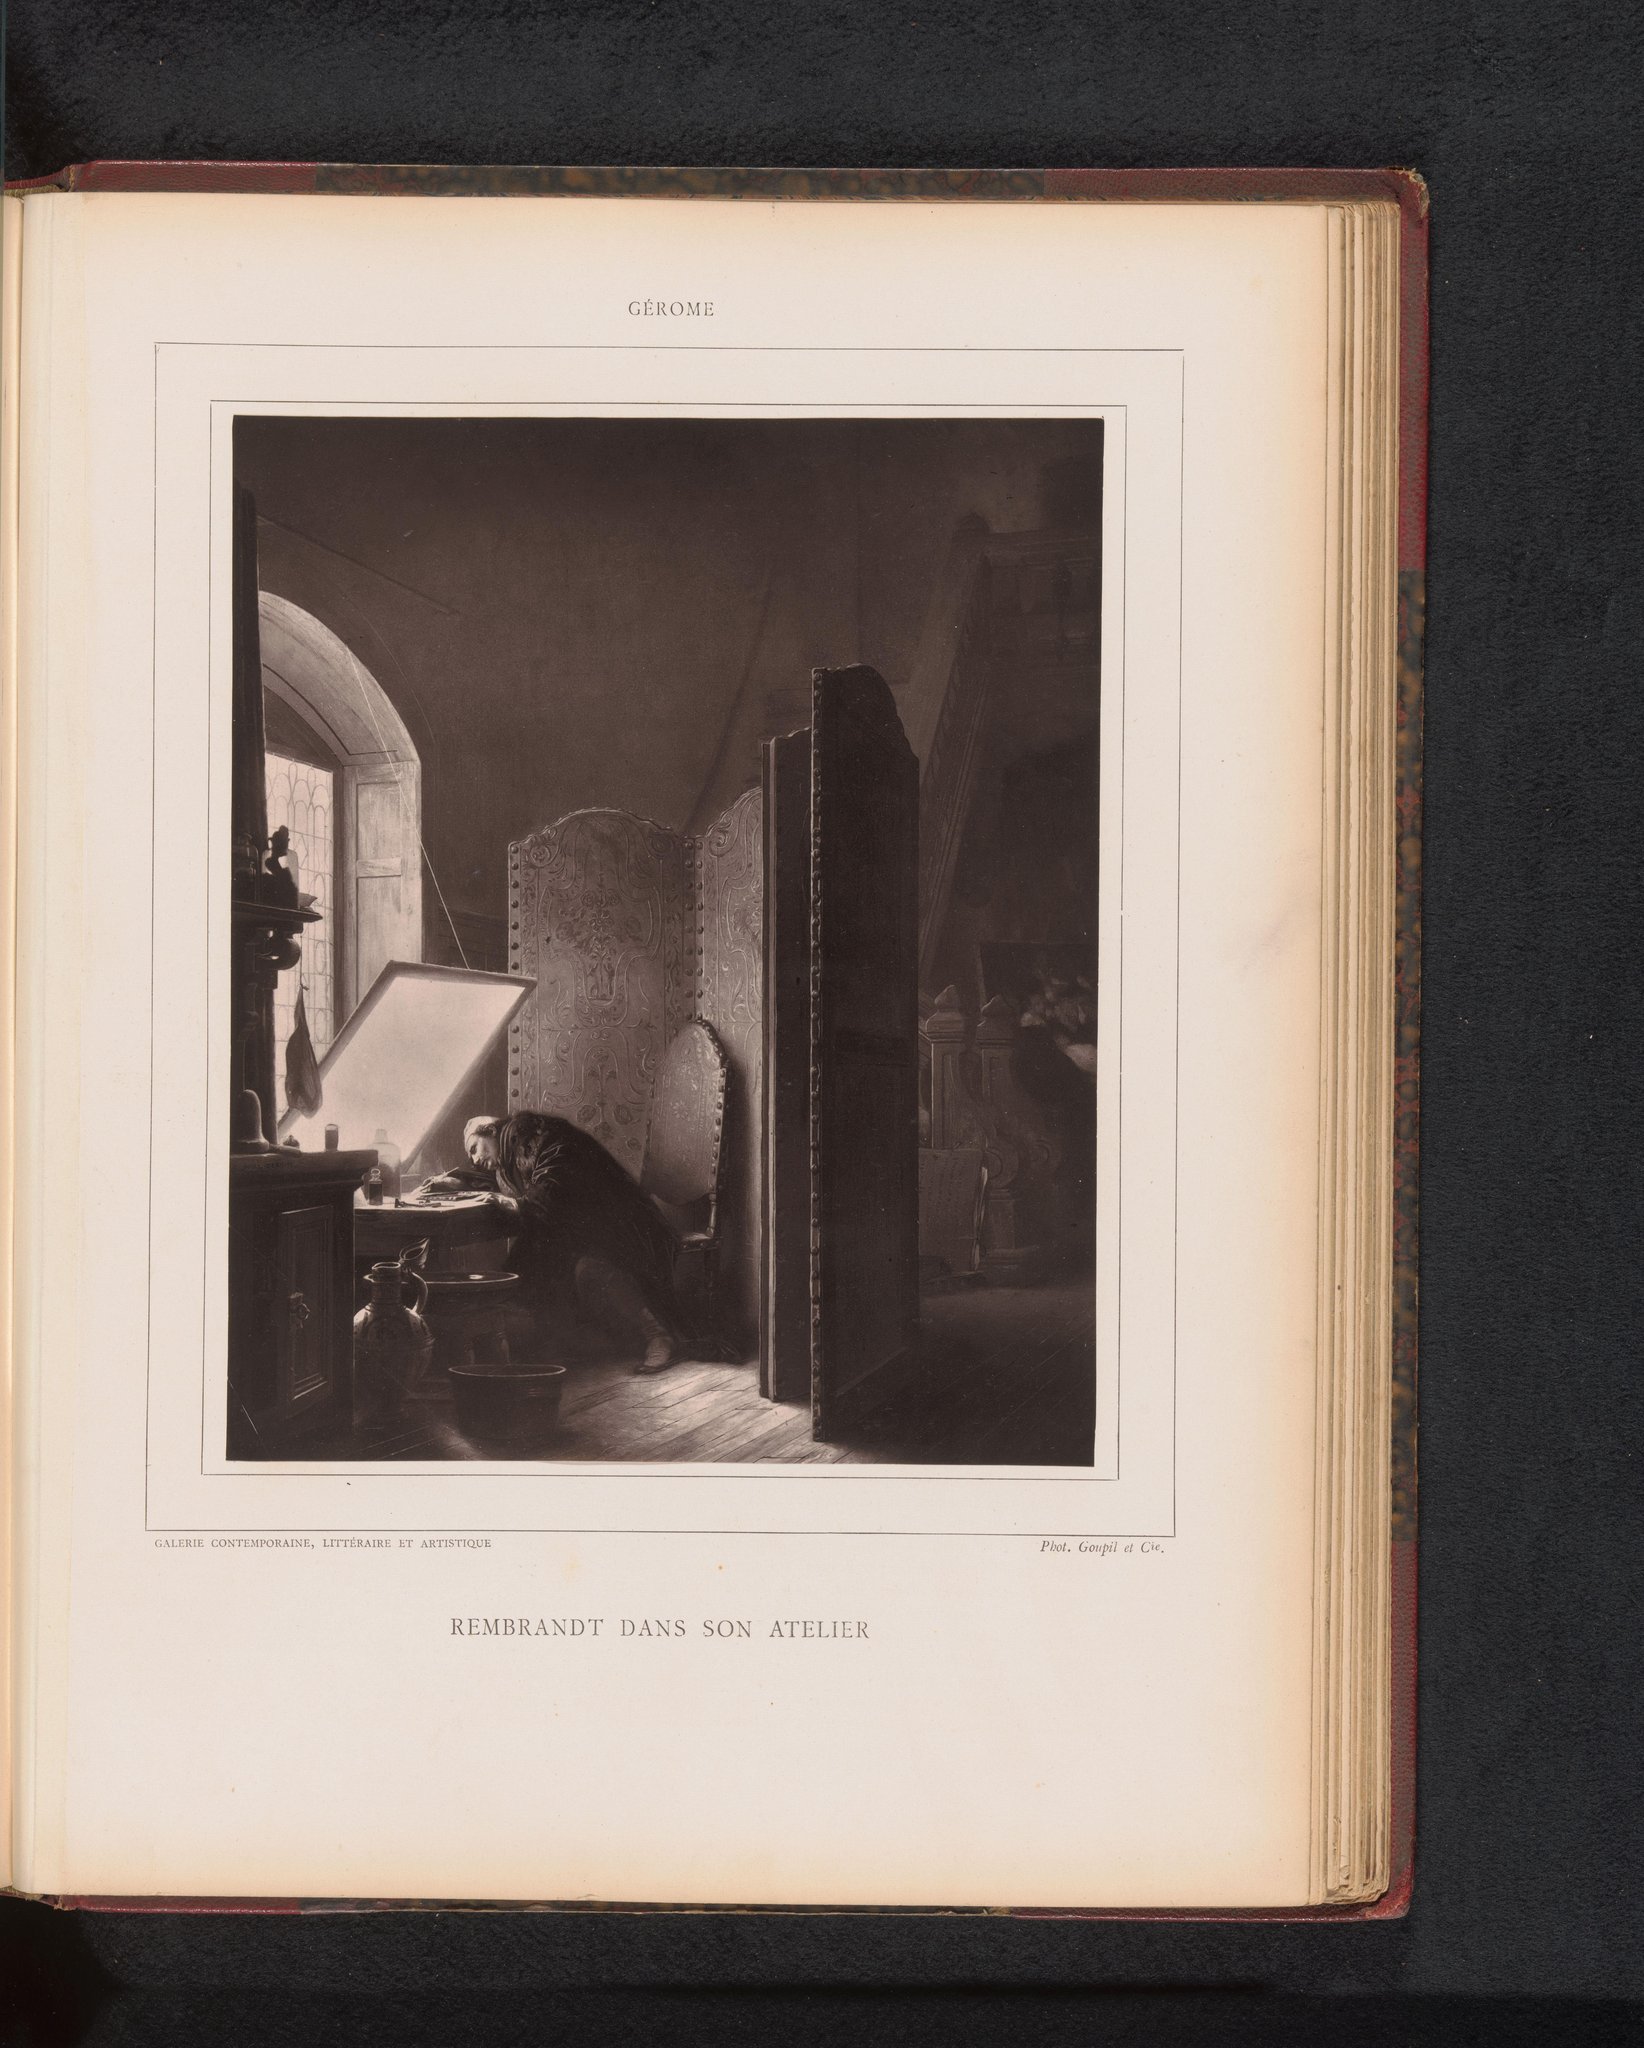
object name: photomechanical print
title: Rembrandt dans son atelier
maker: jean-léon gérôme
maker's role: draughtsman, painter, print maker, sculptor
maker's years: 1824-1904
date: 1873-1878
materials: paper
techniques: woodburytype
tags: leiden, amsterdam, print maker, draughtsman, rembrandt van rijn, painter at work, in his studio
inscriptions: inscription: ‘Galerie Contemporaine, Littéraire et Artistique.’